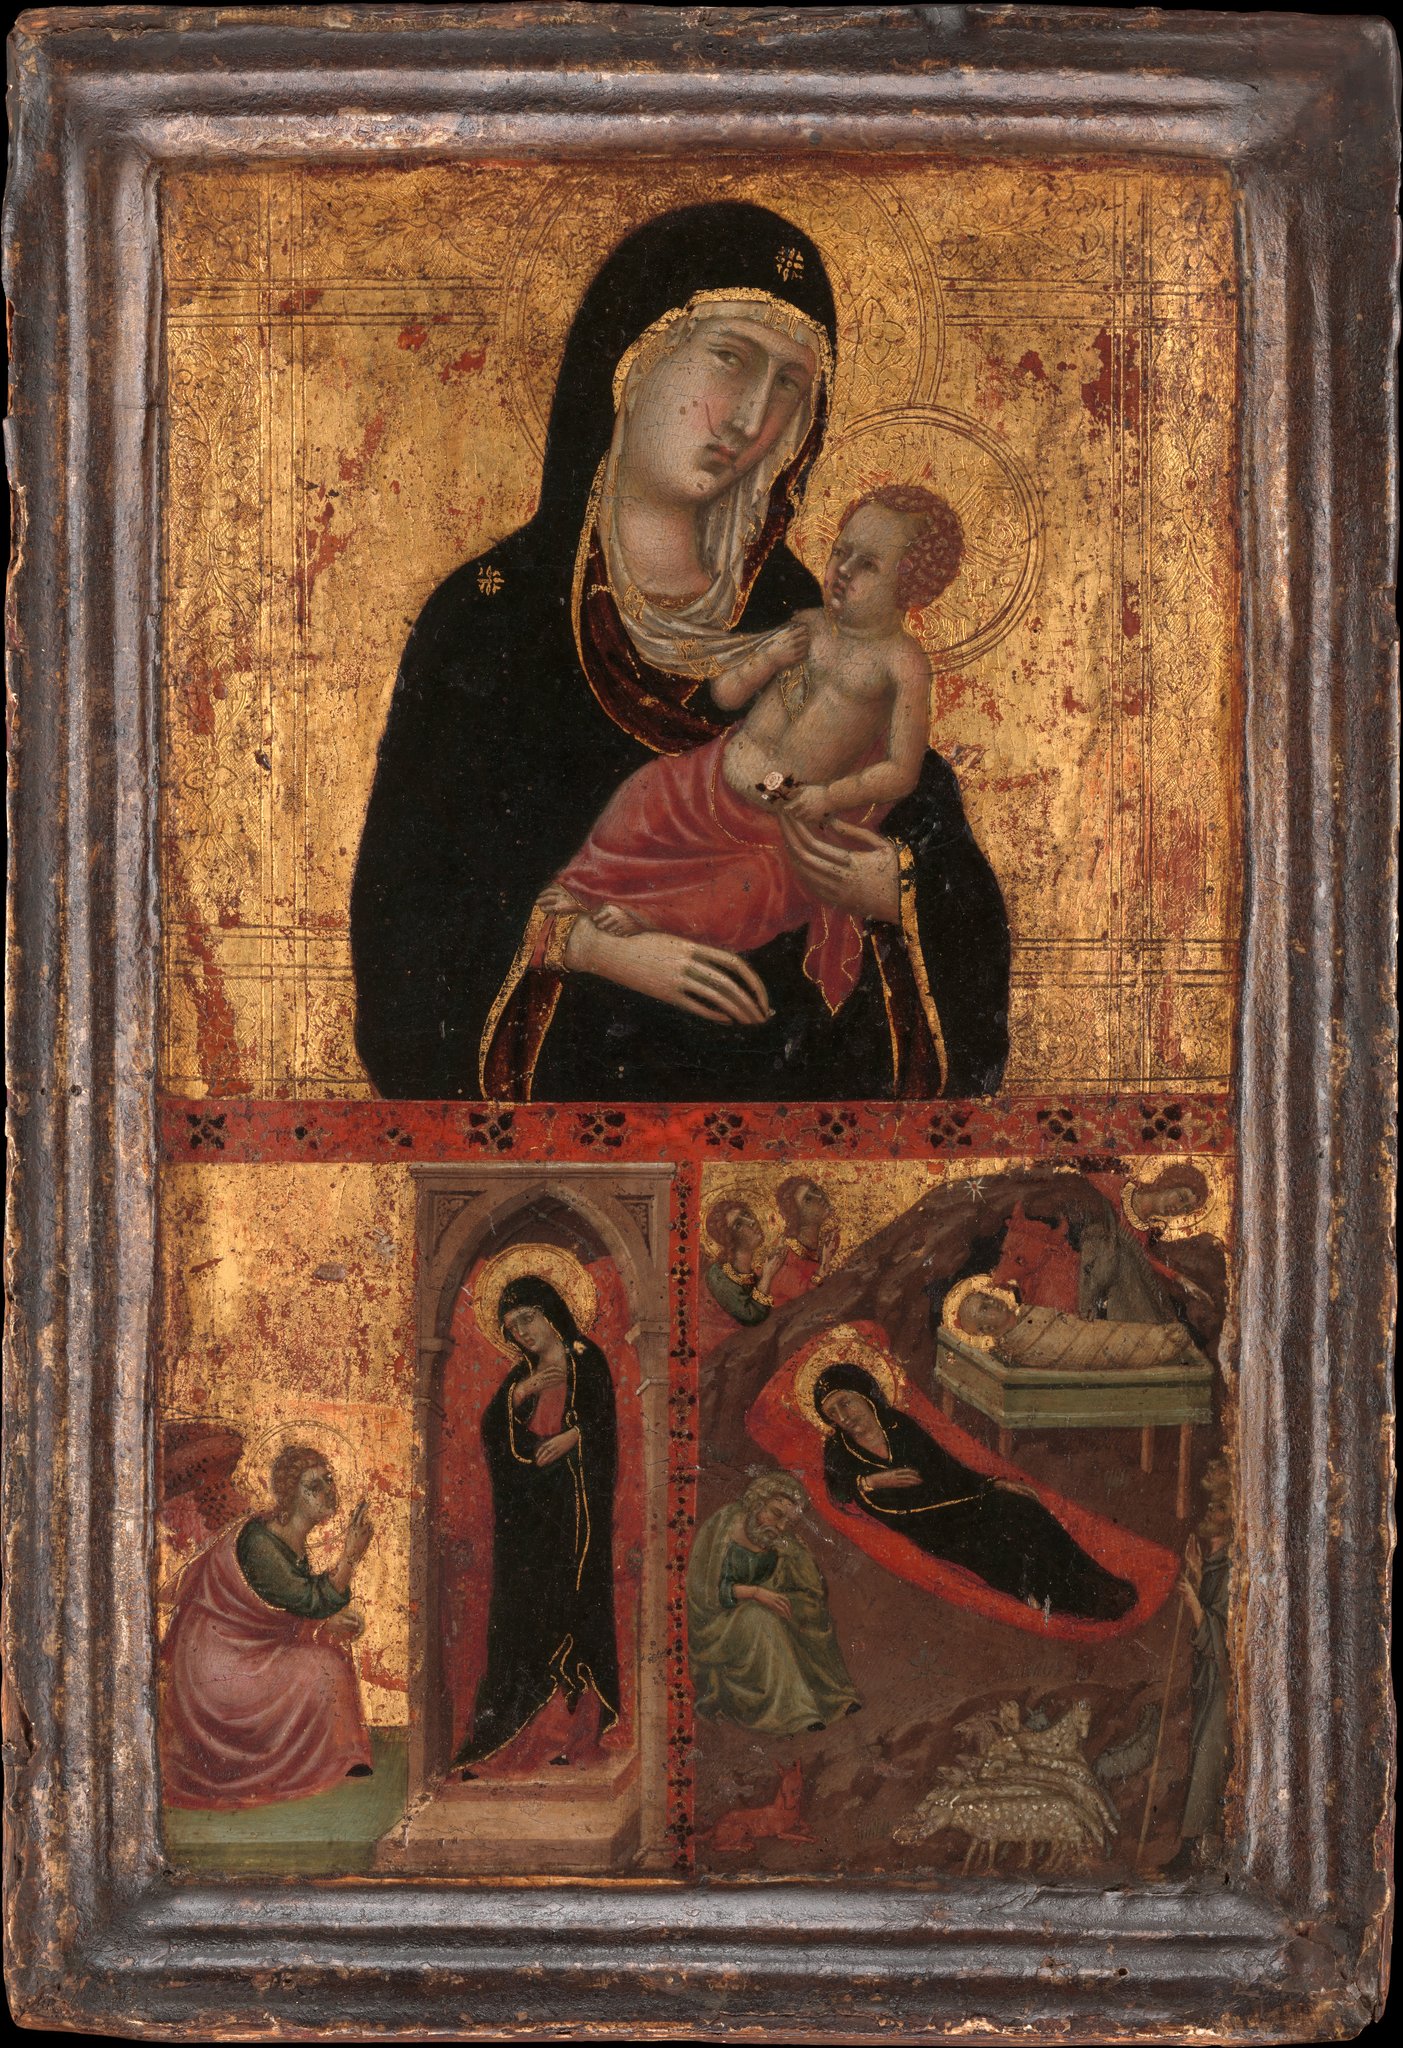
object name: painting, left wing of a diptych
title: Madonna and Child with the Annunciation and the Nativity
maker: goodhart ducciesque master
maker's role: artist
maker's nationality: italian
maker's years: 1310-1330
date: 1310-1315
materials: gold leaf, paint, wood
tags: madonna and child,annunciation,nativity